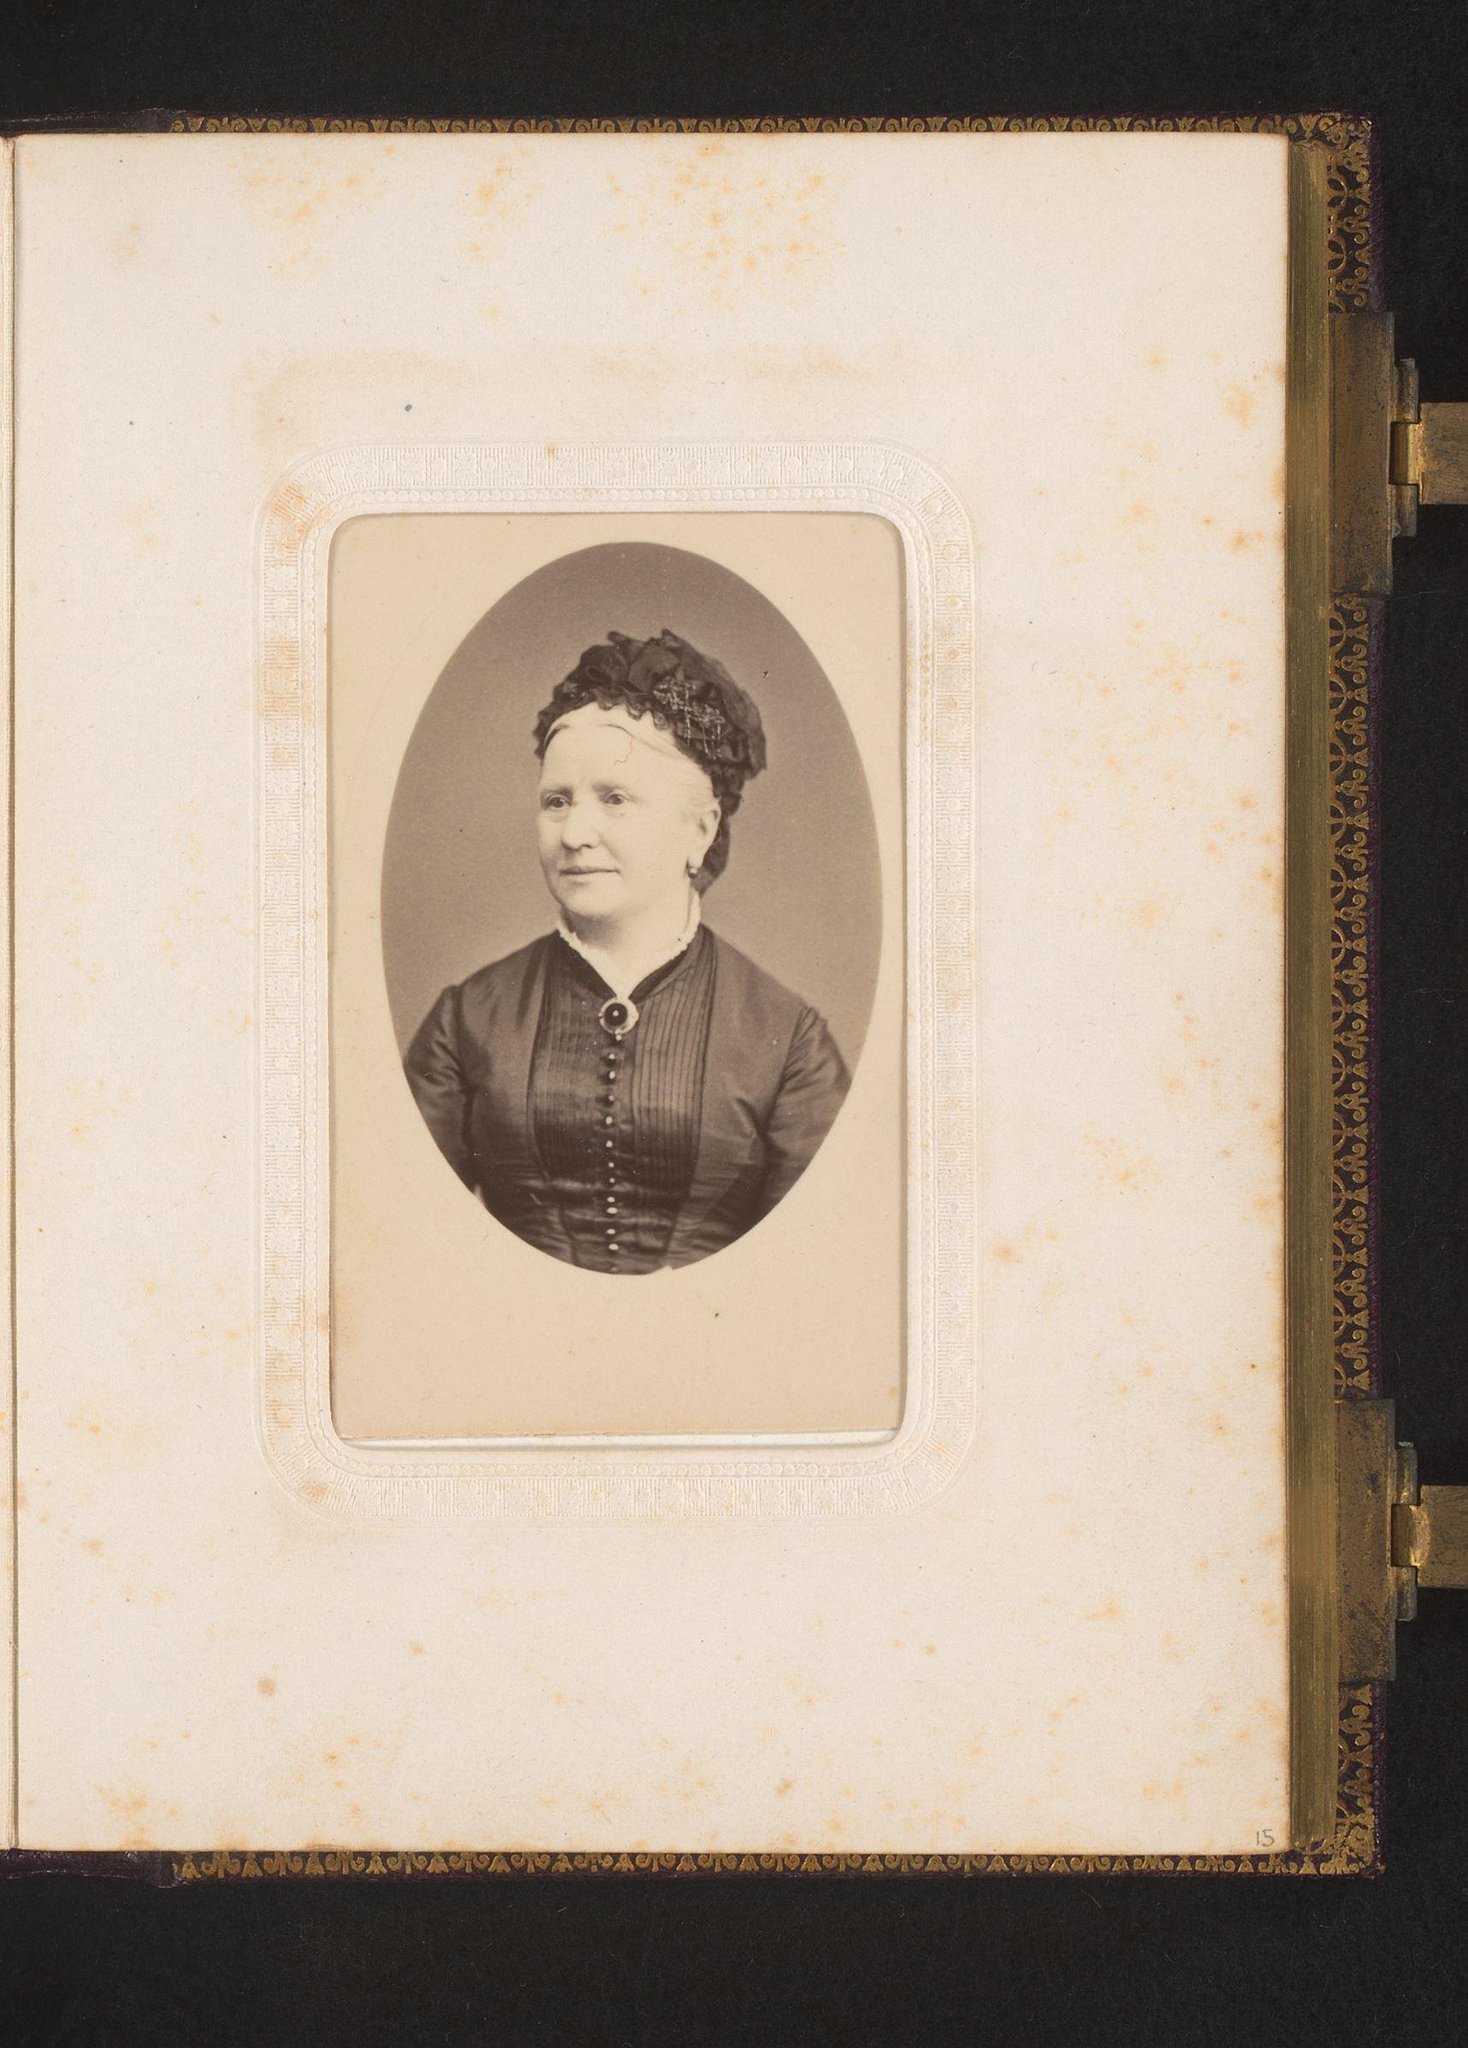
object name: album leaf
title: Portret van een vrouw met muts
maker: charles jacotin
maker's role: fotograaf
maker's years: 1863-1895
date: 1882-1900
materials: cardboard, celluloid, photographic support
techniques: albumen print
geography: paris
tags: historical persons - bb - woman, head-gear: cap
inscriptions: inscription: ‘Photographie/ CH. JACOTIN/ 37, Bould. de Strasbourg/ PARIS/ No. .../ Il suffit de rappeler ce No./ pour avoir des cartes sembables/ 1882’